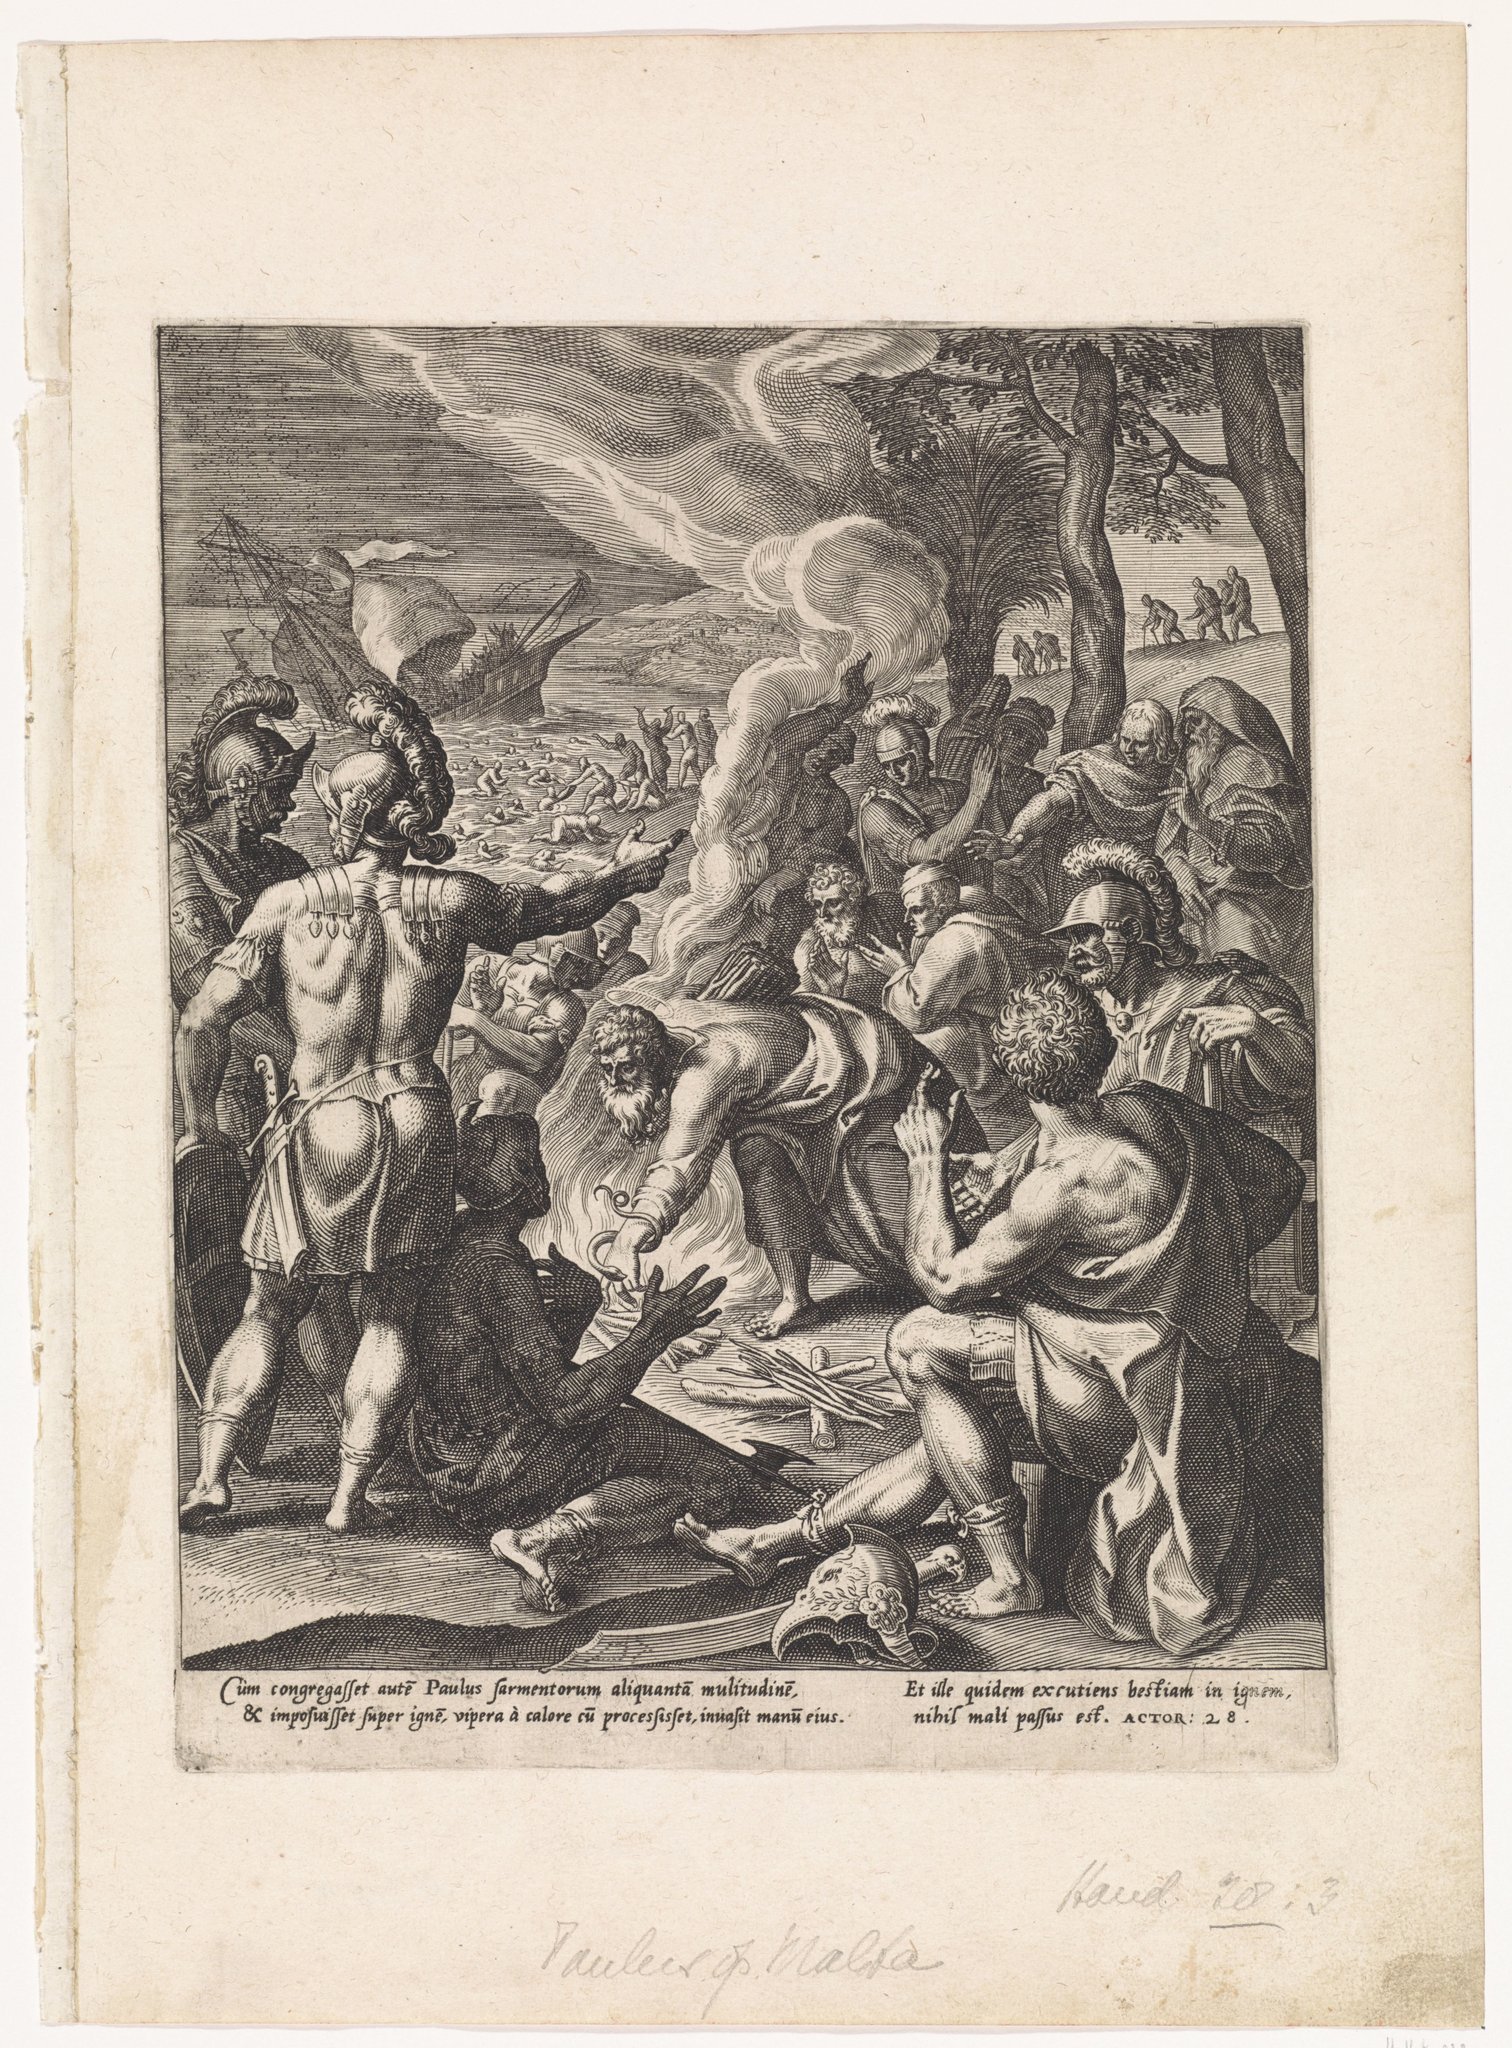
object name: print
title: Scènes uit het leven van de apostel Paulus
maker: johann sadeler (i)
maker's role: print maker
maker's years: 1550-1600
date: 1580-1581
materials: paper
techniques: engraving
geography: cologne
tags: paul bitten by a viper (when throwing wood on the fire), the shipwreck on the coast of malta (melita) ~ story of paul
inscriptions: collector's mark: Lugt 2228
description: Op de voorgrond wordt Paulus op Malta bij het maken van vuur door een adder gebeten. Ongedeerd gooit hij het beest in het vuur. Op de achtergrond lijdt Paulus schipbreuk bij Malta. Met een Latijns onderschrift met een Bijbelpassage uit de Handelingen van de Apostelen (Hand. 28). De vierde prent van een vierdelige serie.